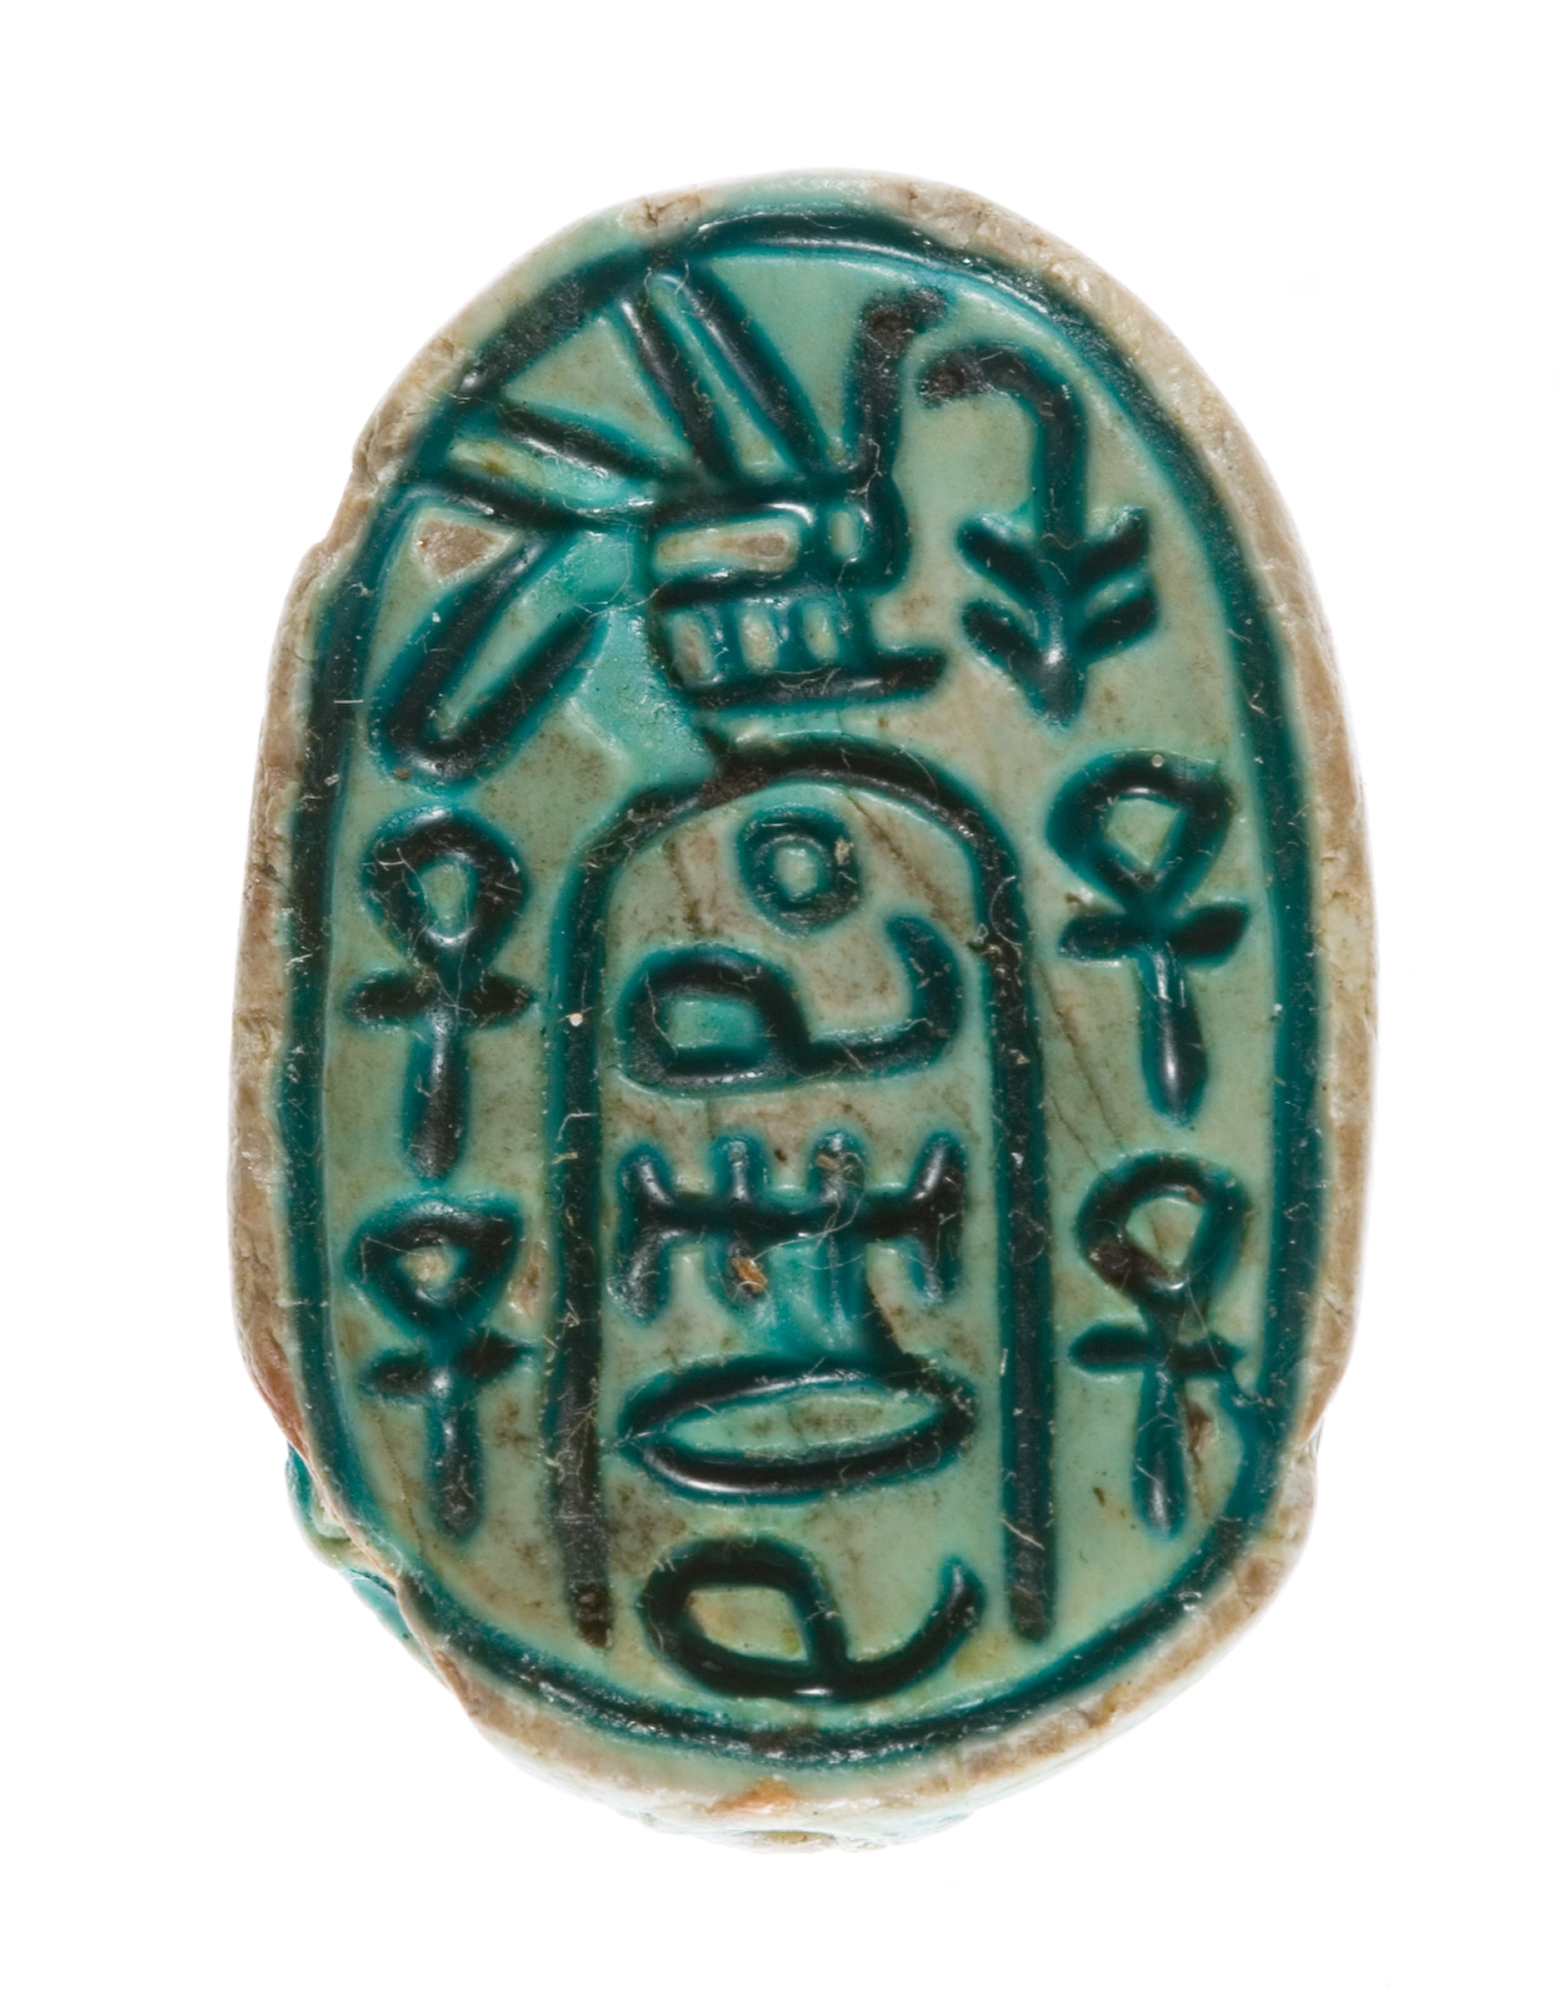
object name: scarab, anra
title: Canaanite Scarab of the "Anra" Type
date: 1648-1540 BCE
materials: stone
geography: canaan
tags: hieroglyphs,scarabs